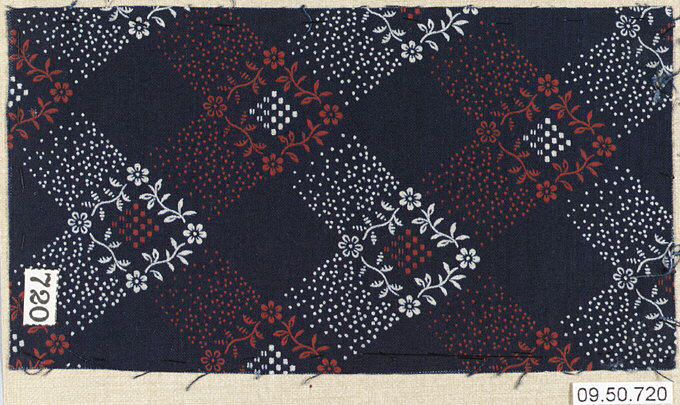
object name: piece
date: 1801-1900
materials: cotton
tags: flowers